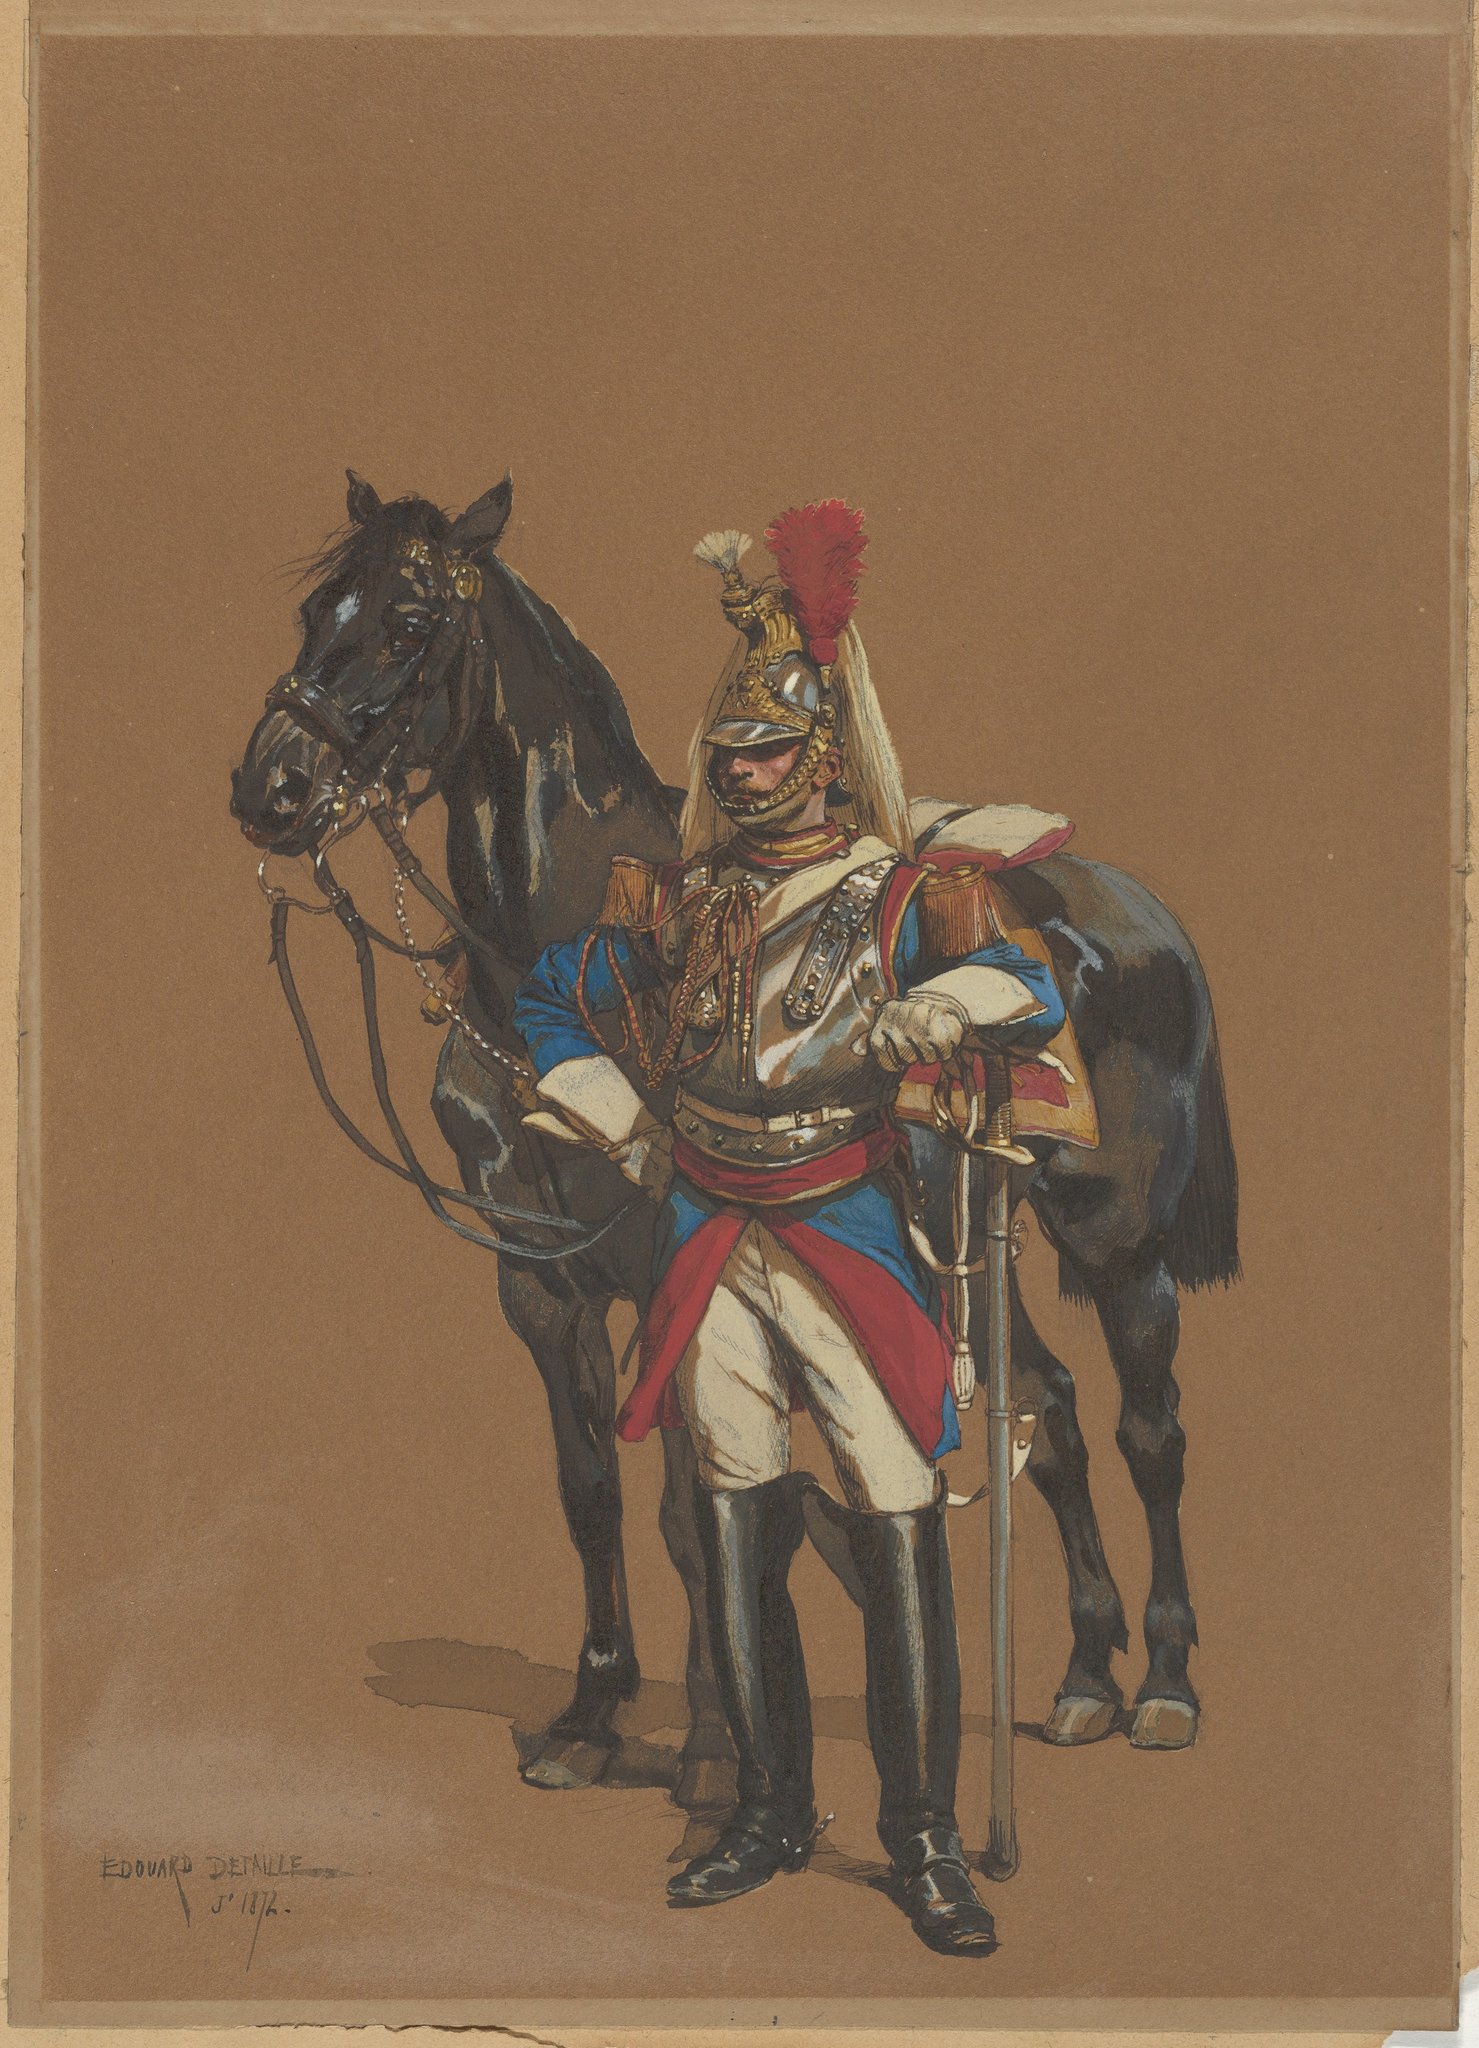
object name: drawing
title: Cuirassier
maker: edouard detaille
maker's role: artist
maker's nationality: french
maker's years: 1848-1912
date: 1872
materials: paper, watercolor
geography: france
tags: soldiers,horses